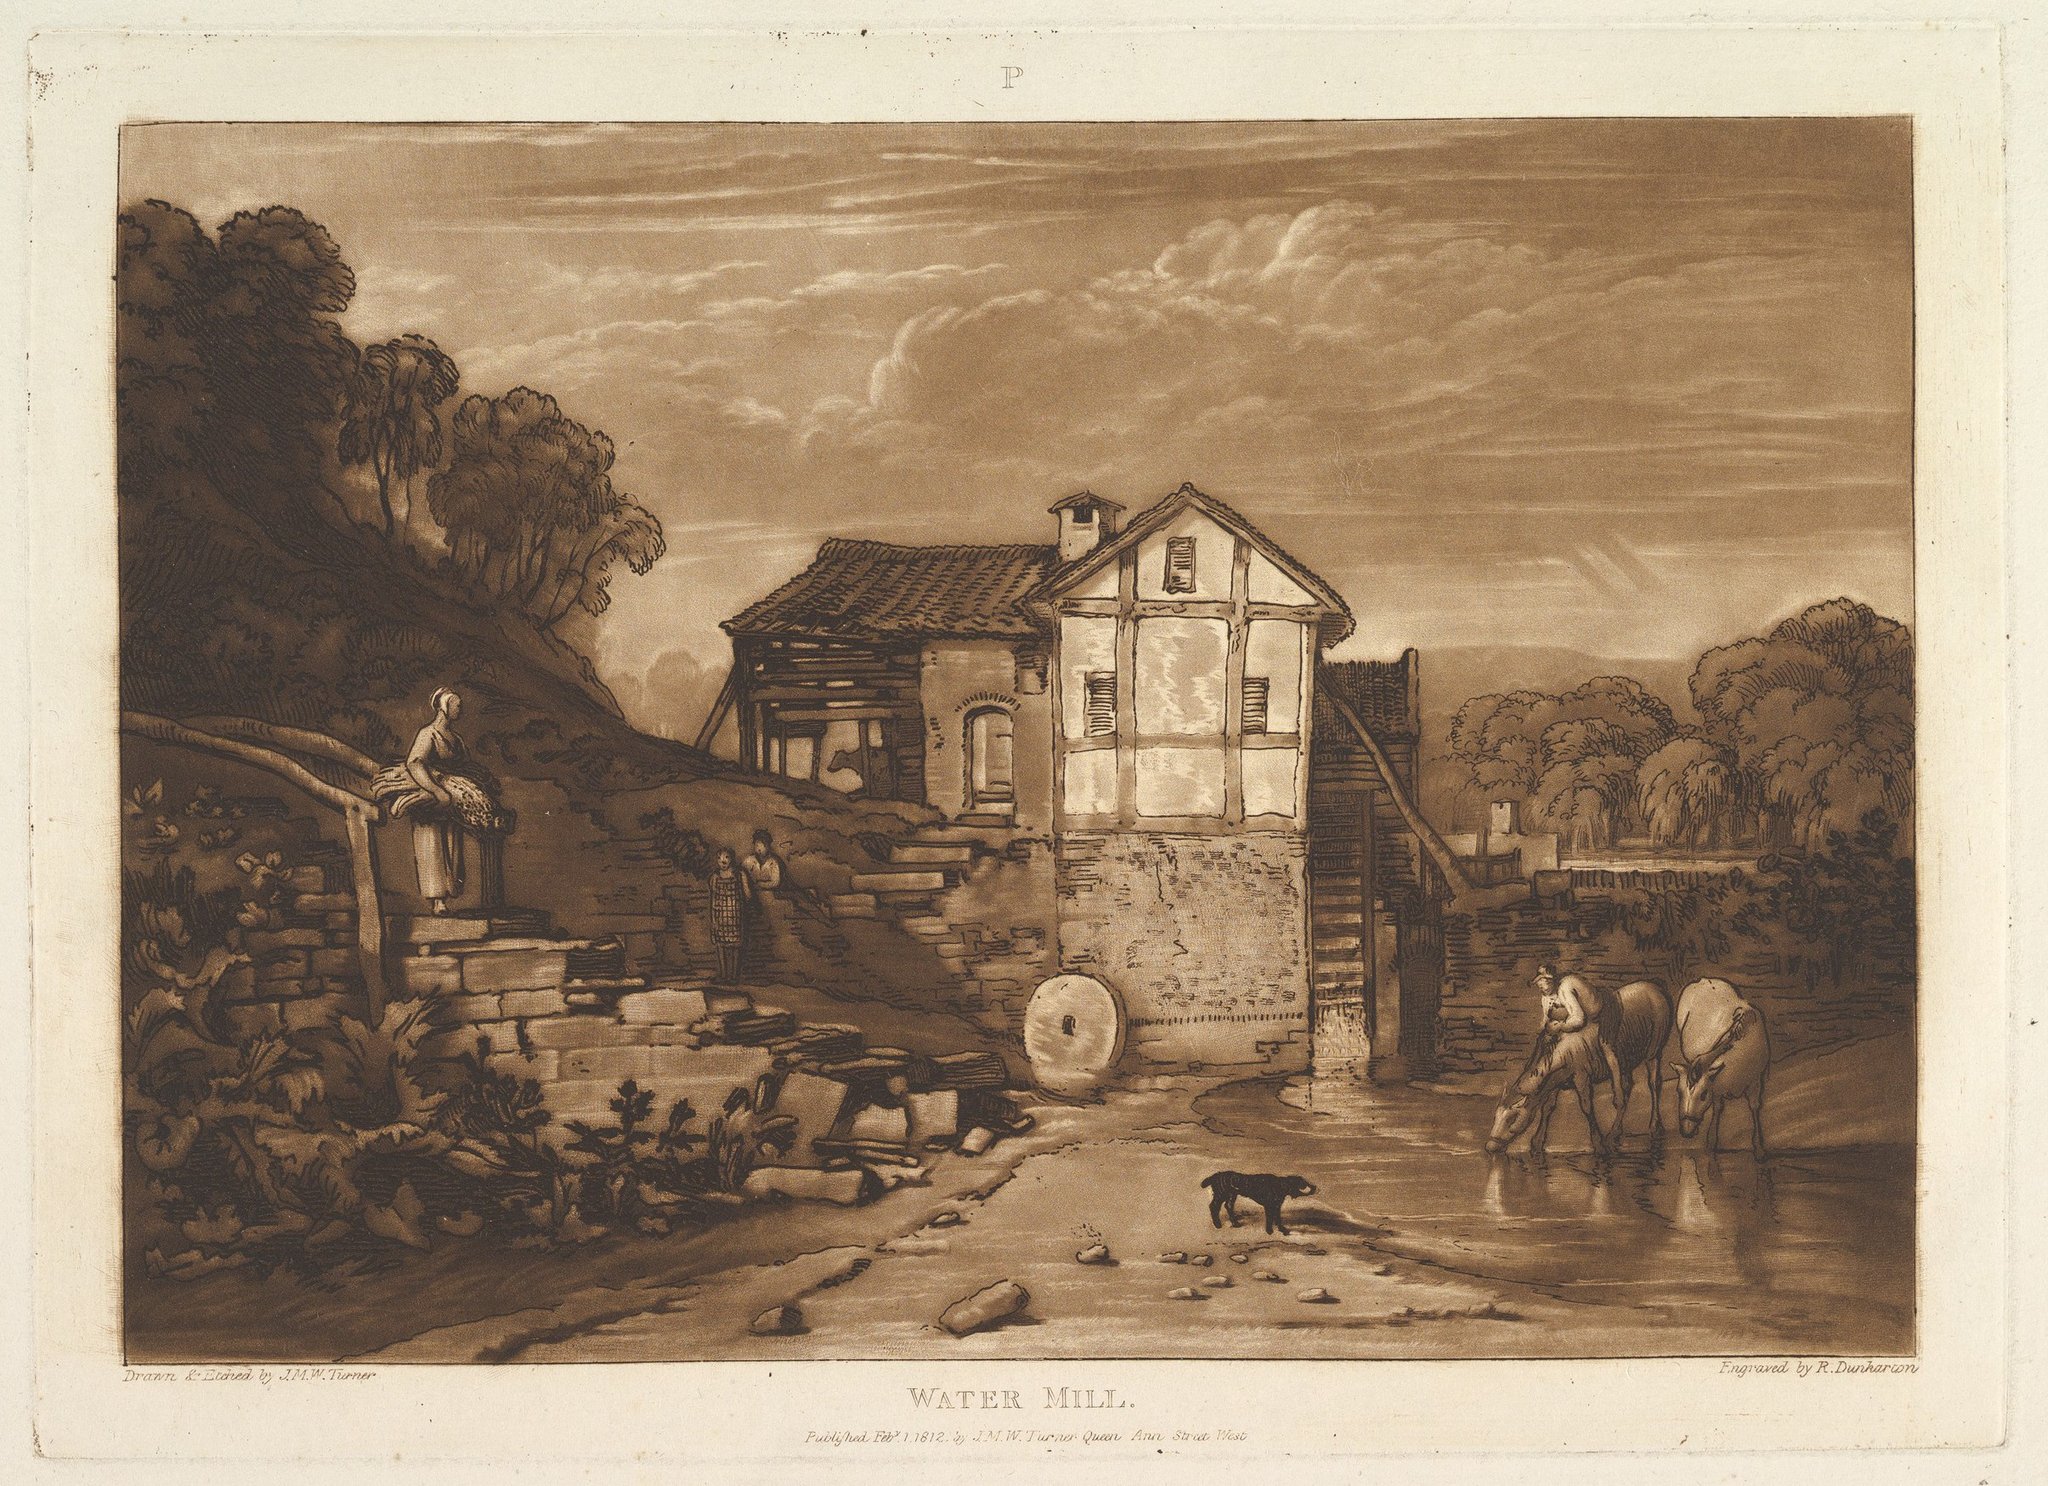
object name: print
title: Water Mill, part VII, plate 37 from "Liber Studiorum"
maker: joseph mallord william turner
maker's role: artist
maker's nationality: british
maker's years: 1775-1851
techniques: etching, mezzotint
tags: human figures,buildings,watermills,horses